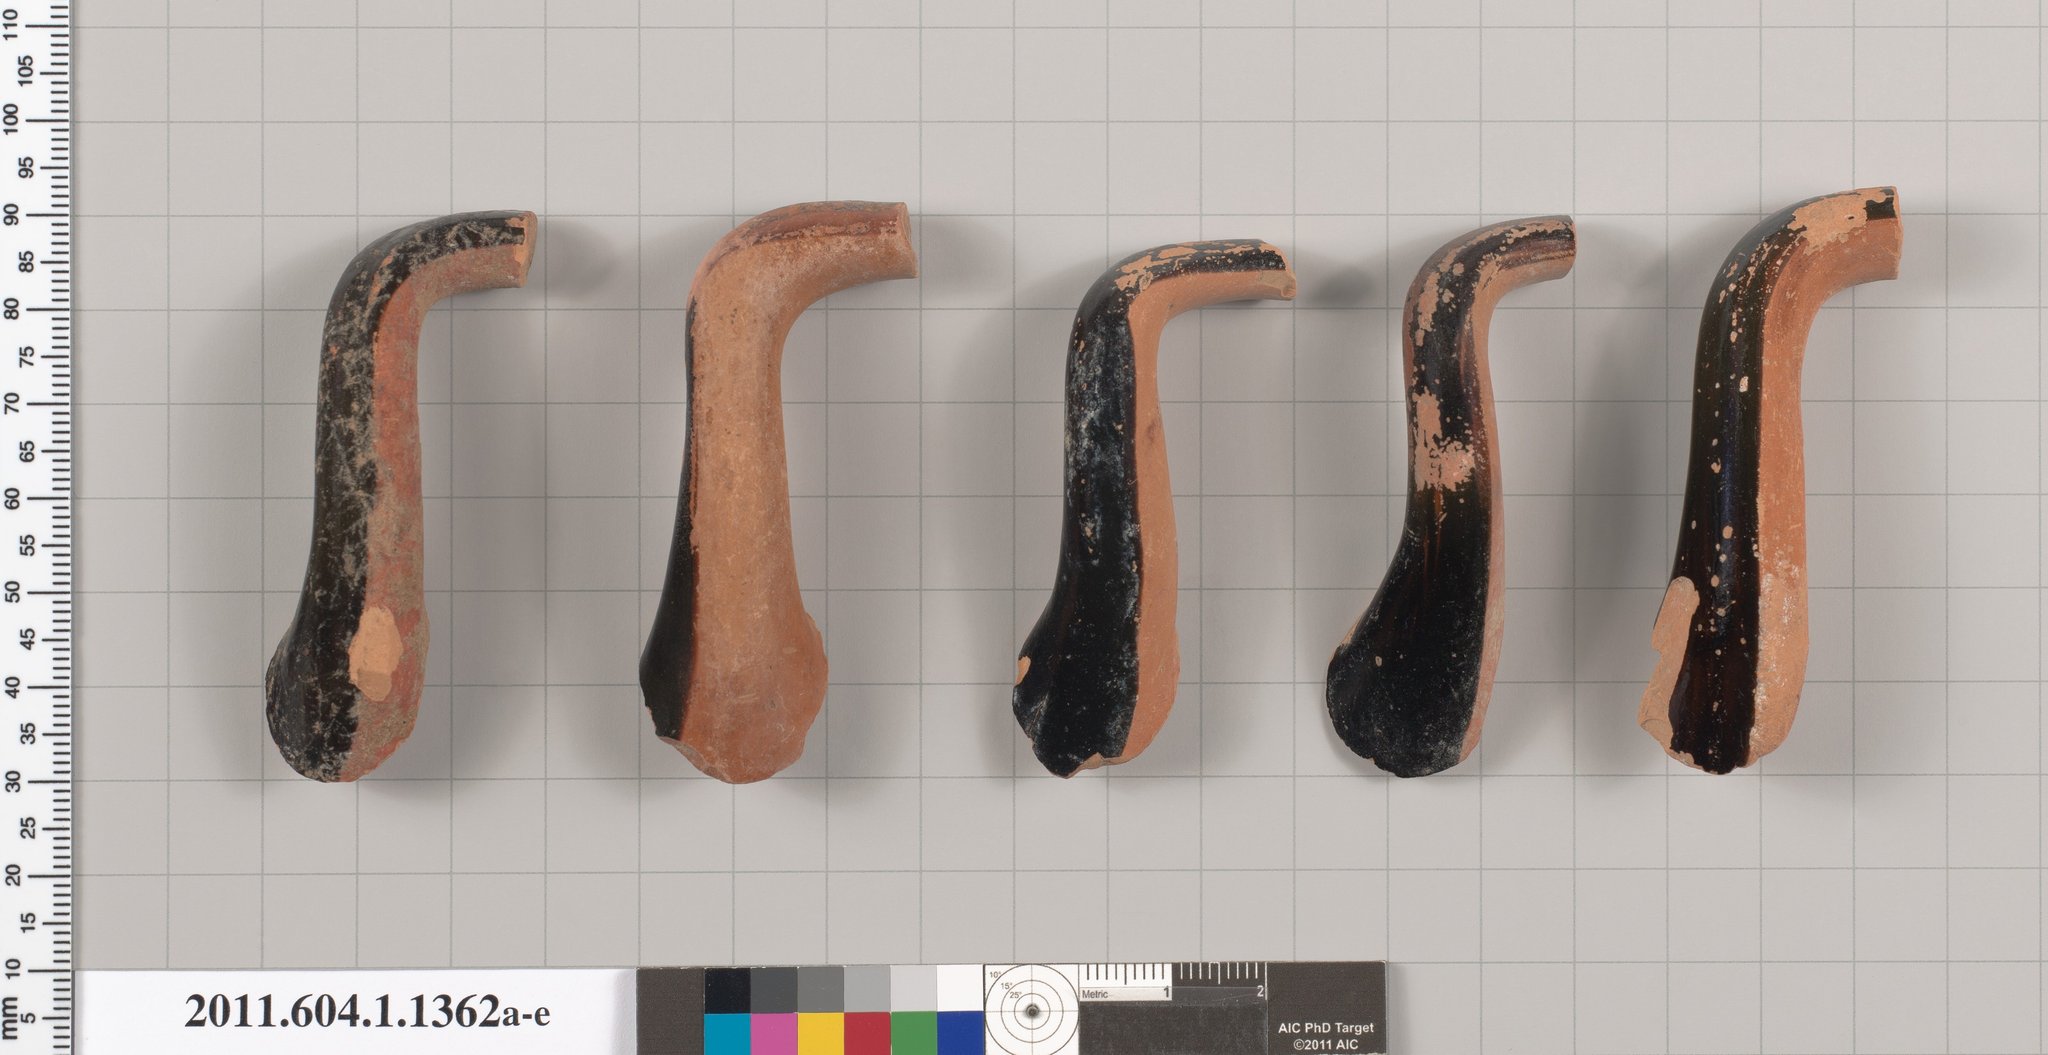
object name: kylix fragment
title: Terracotta fragments of kylikes (drinking cups)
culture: greek, attic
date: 500-401 BCE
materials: terracotta